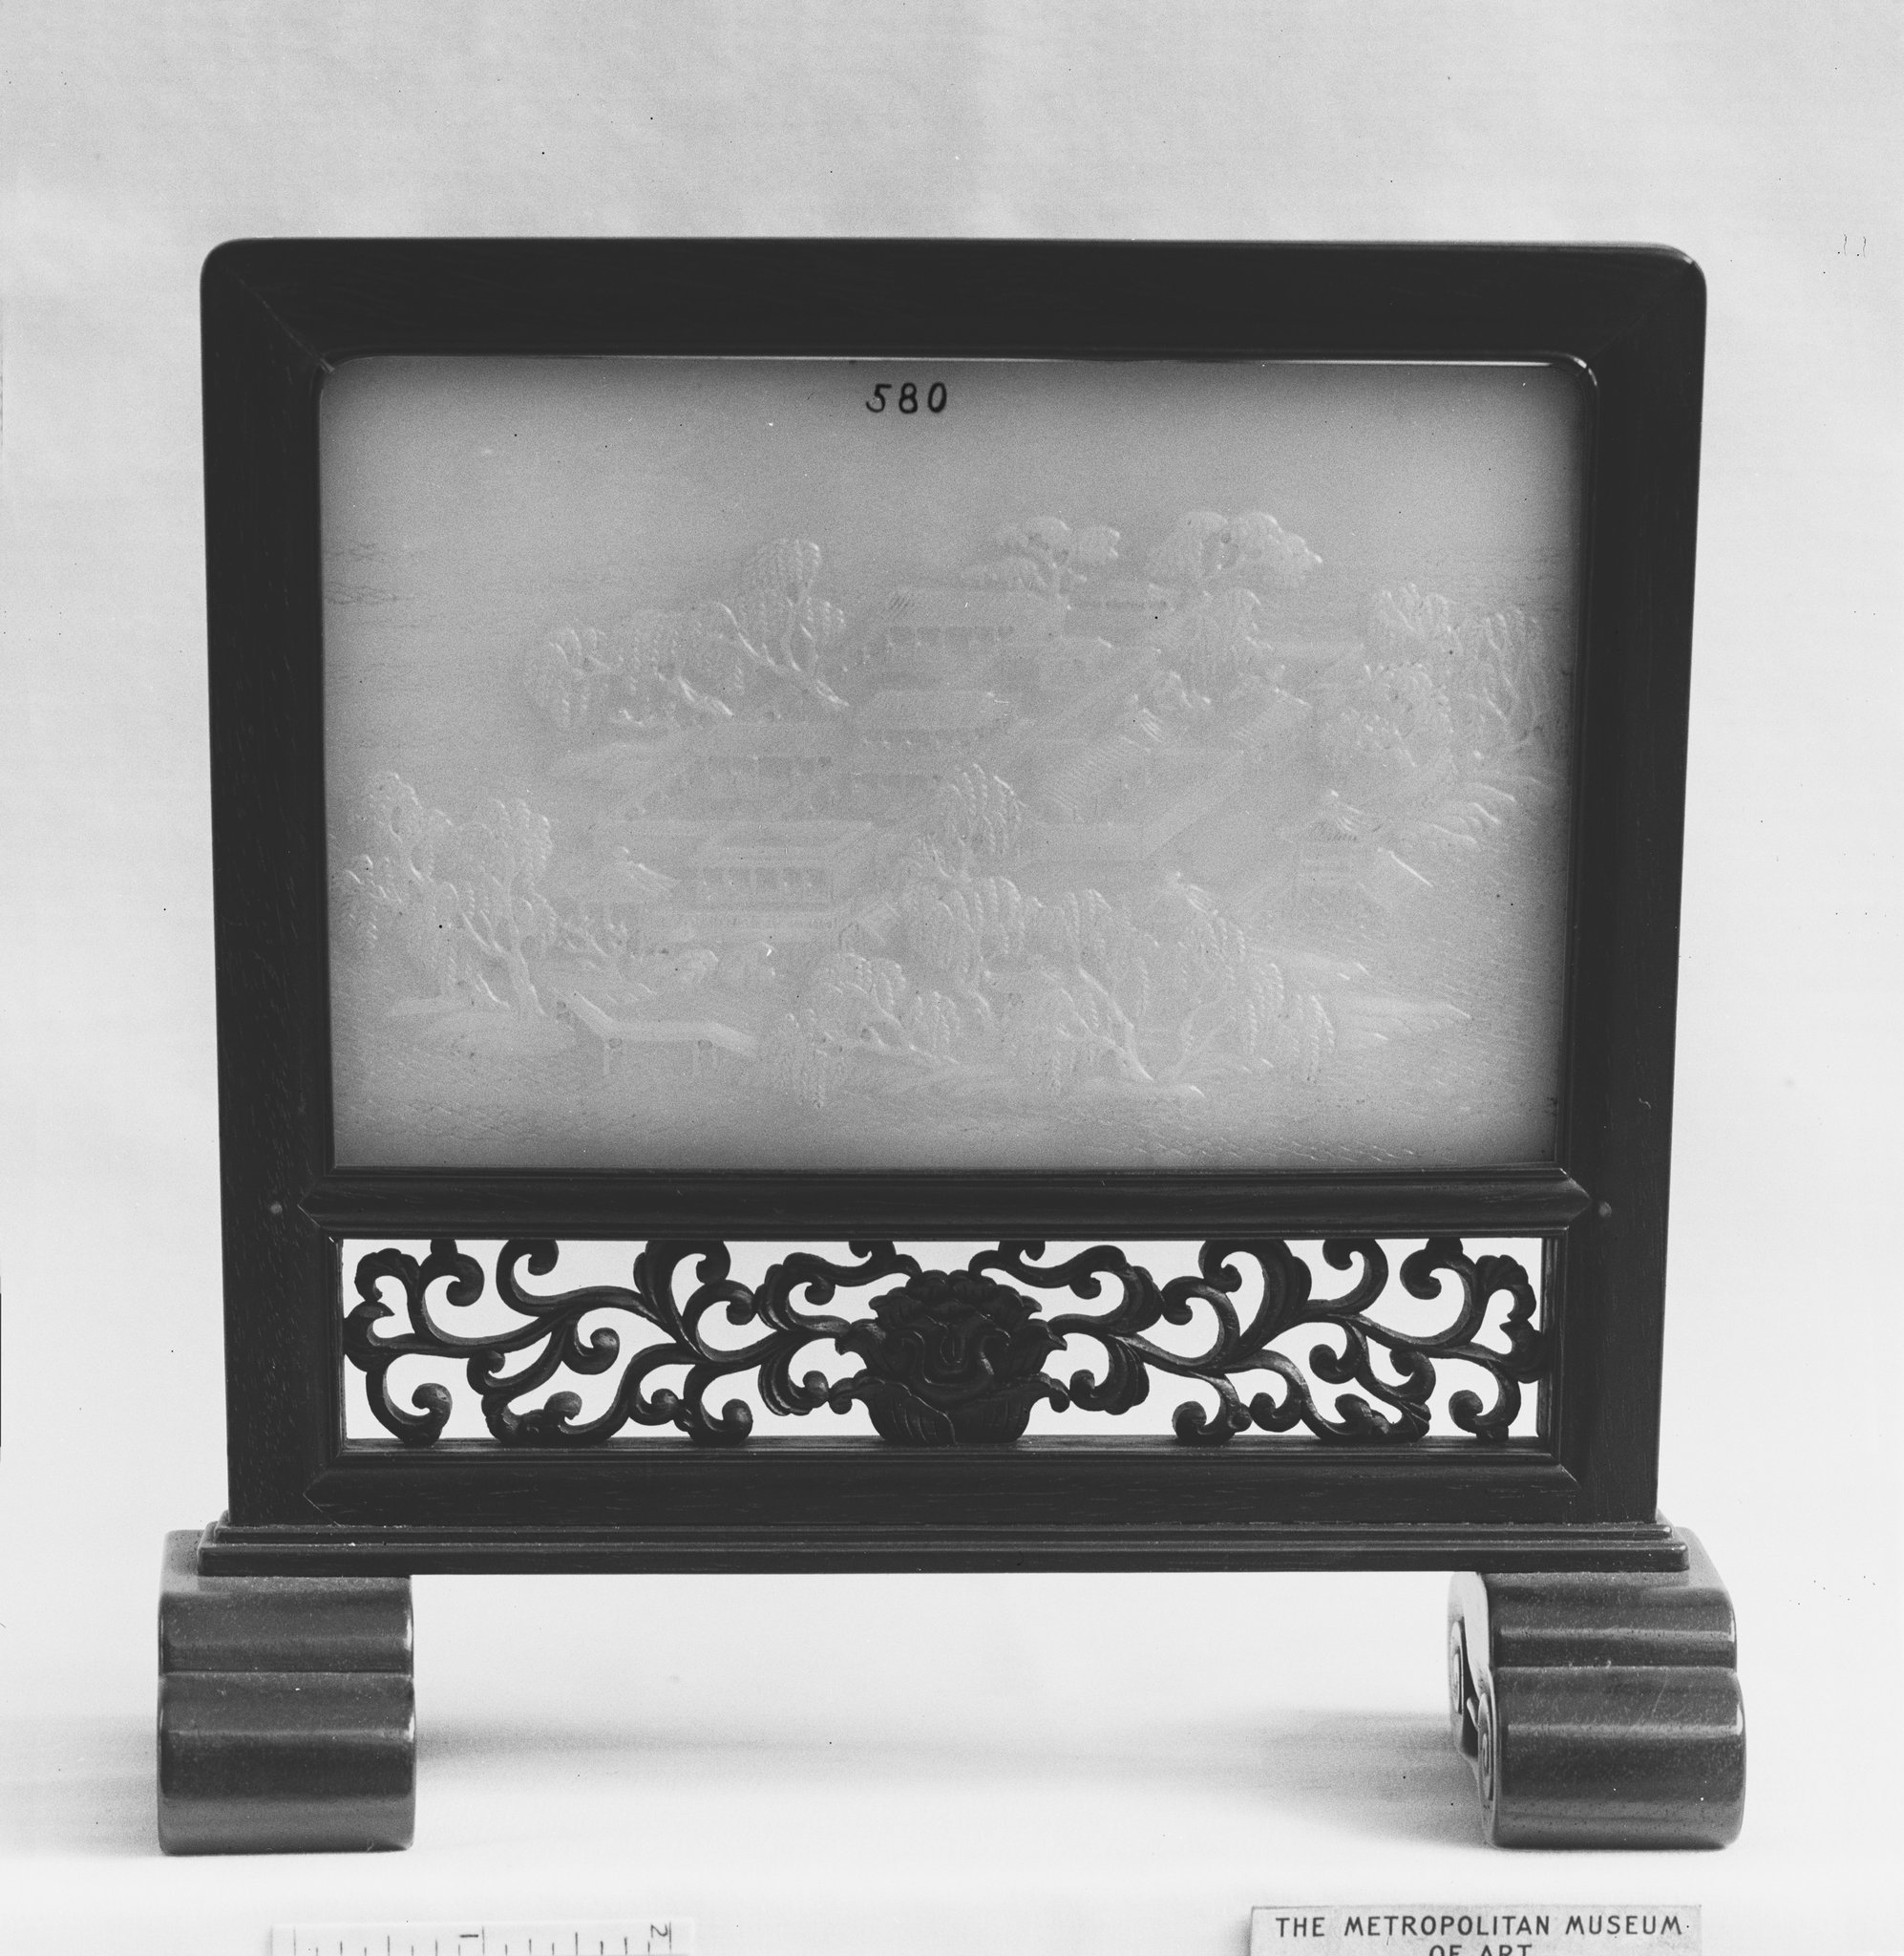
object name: table screen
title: Table Screen with Scene of Imperial Traveling Palace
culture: chinese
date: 1736-1795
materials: jade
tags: palaces